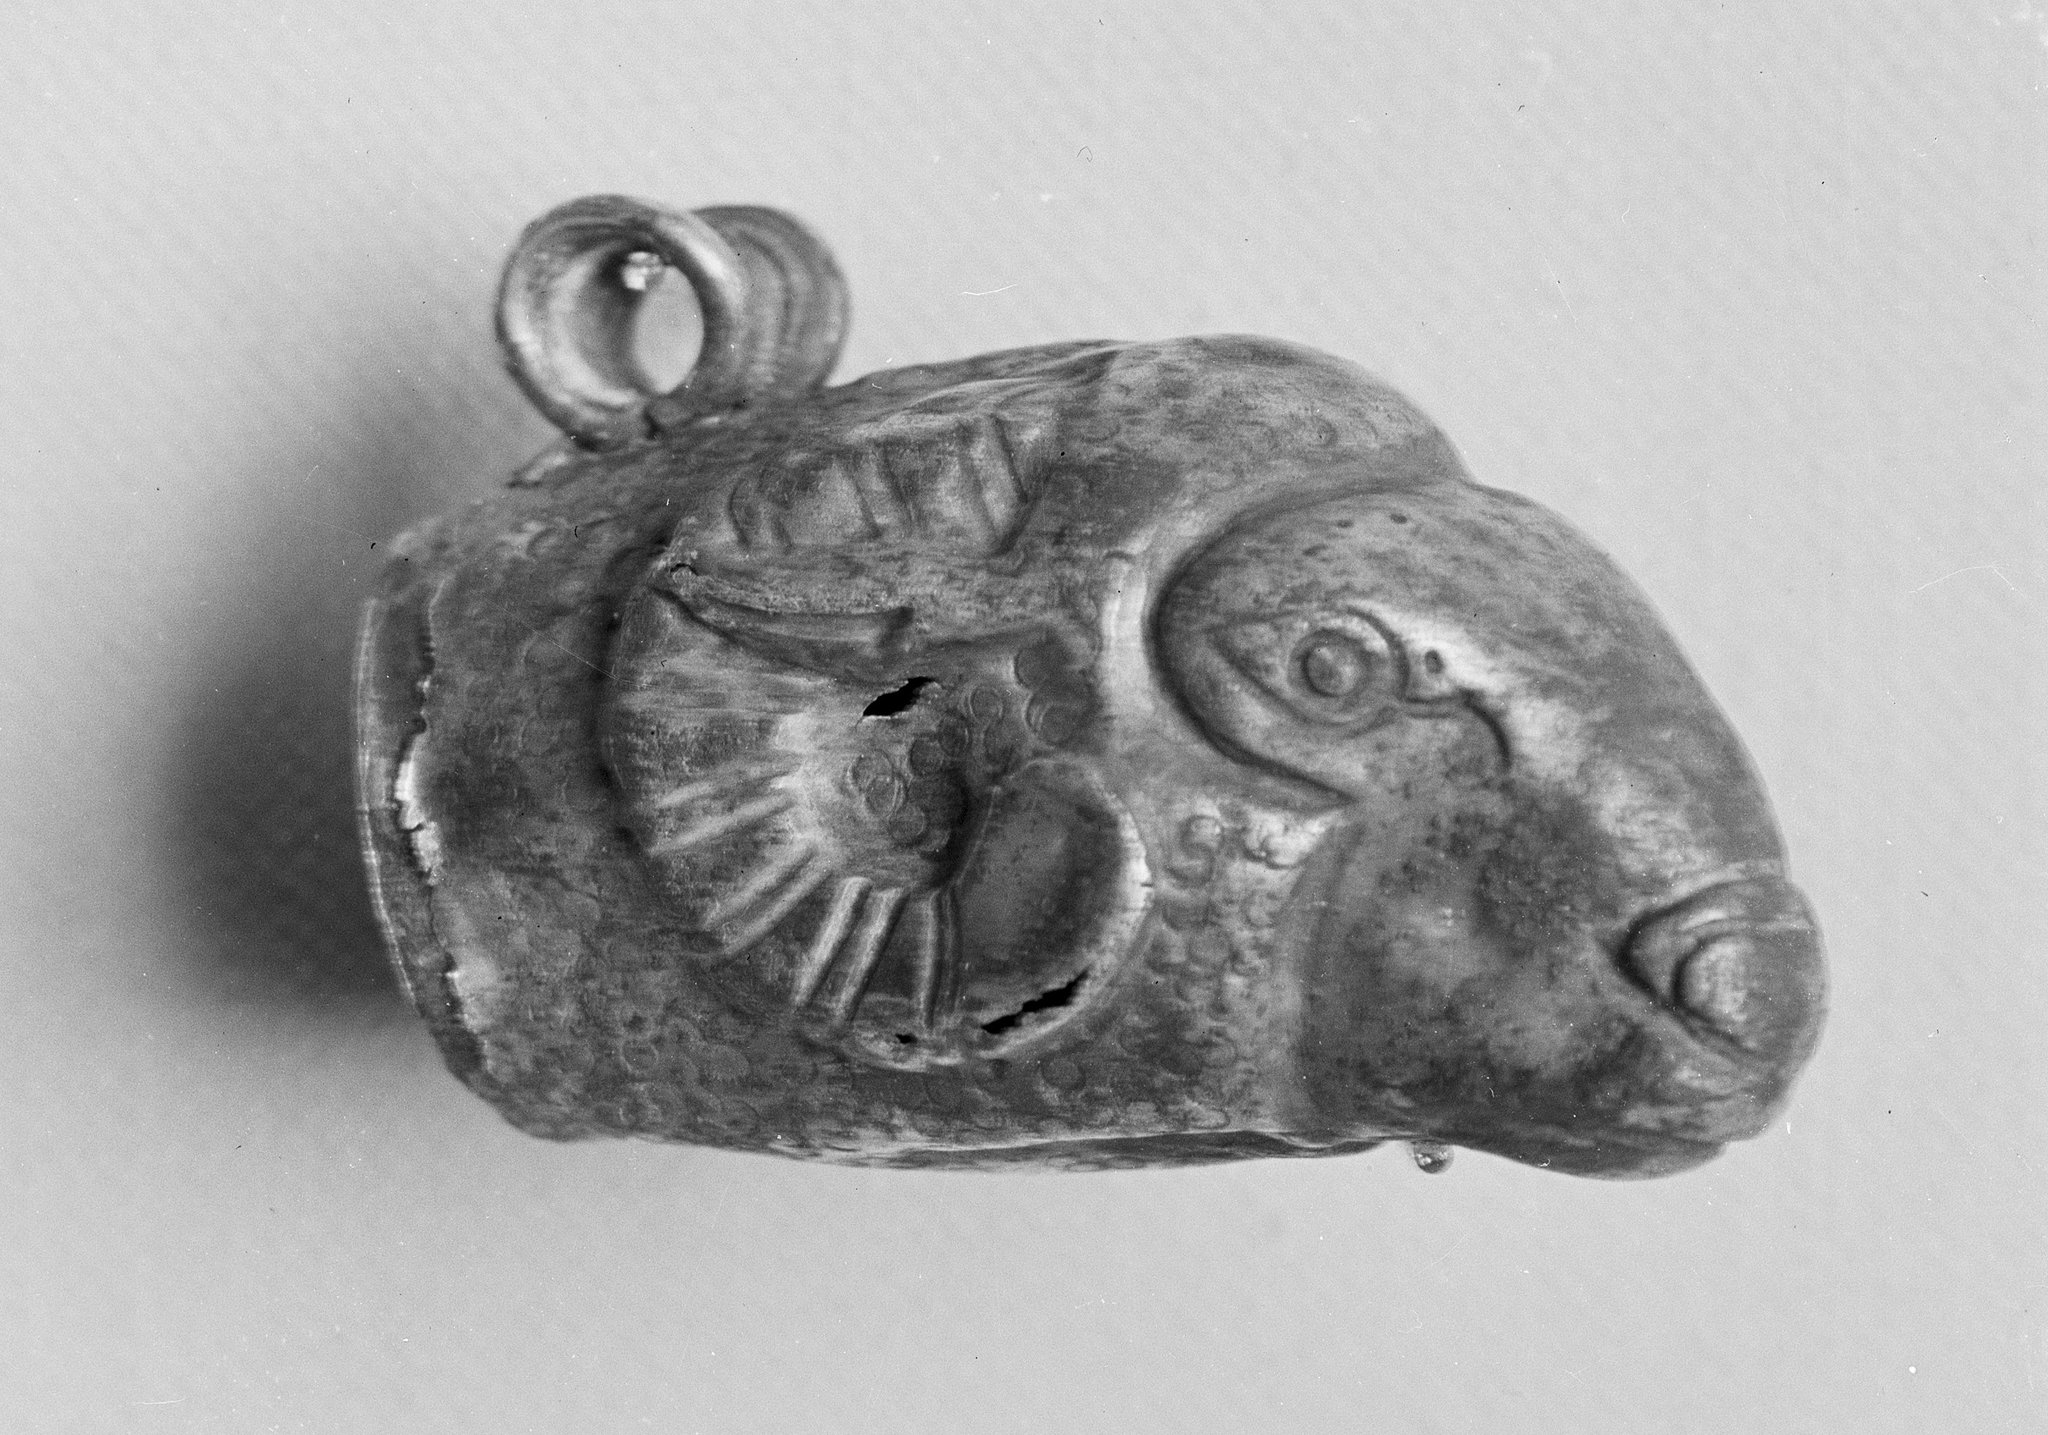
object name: pendant in the form of a ram's head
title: Silver pendant in the form of a ram's head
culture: greek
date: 700-501 BCE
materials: gold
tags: rams